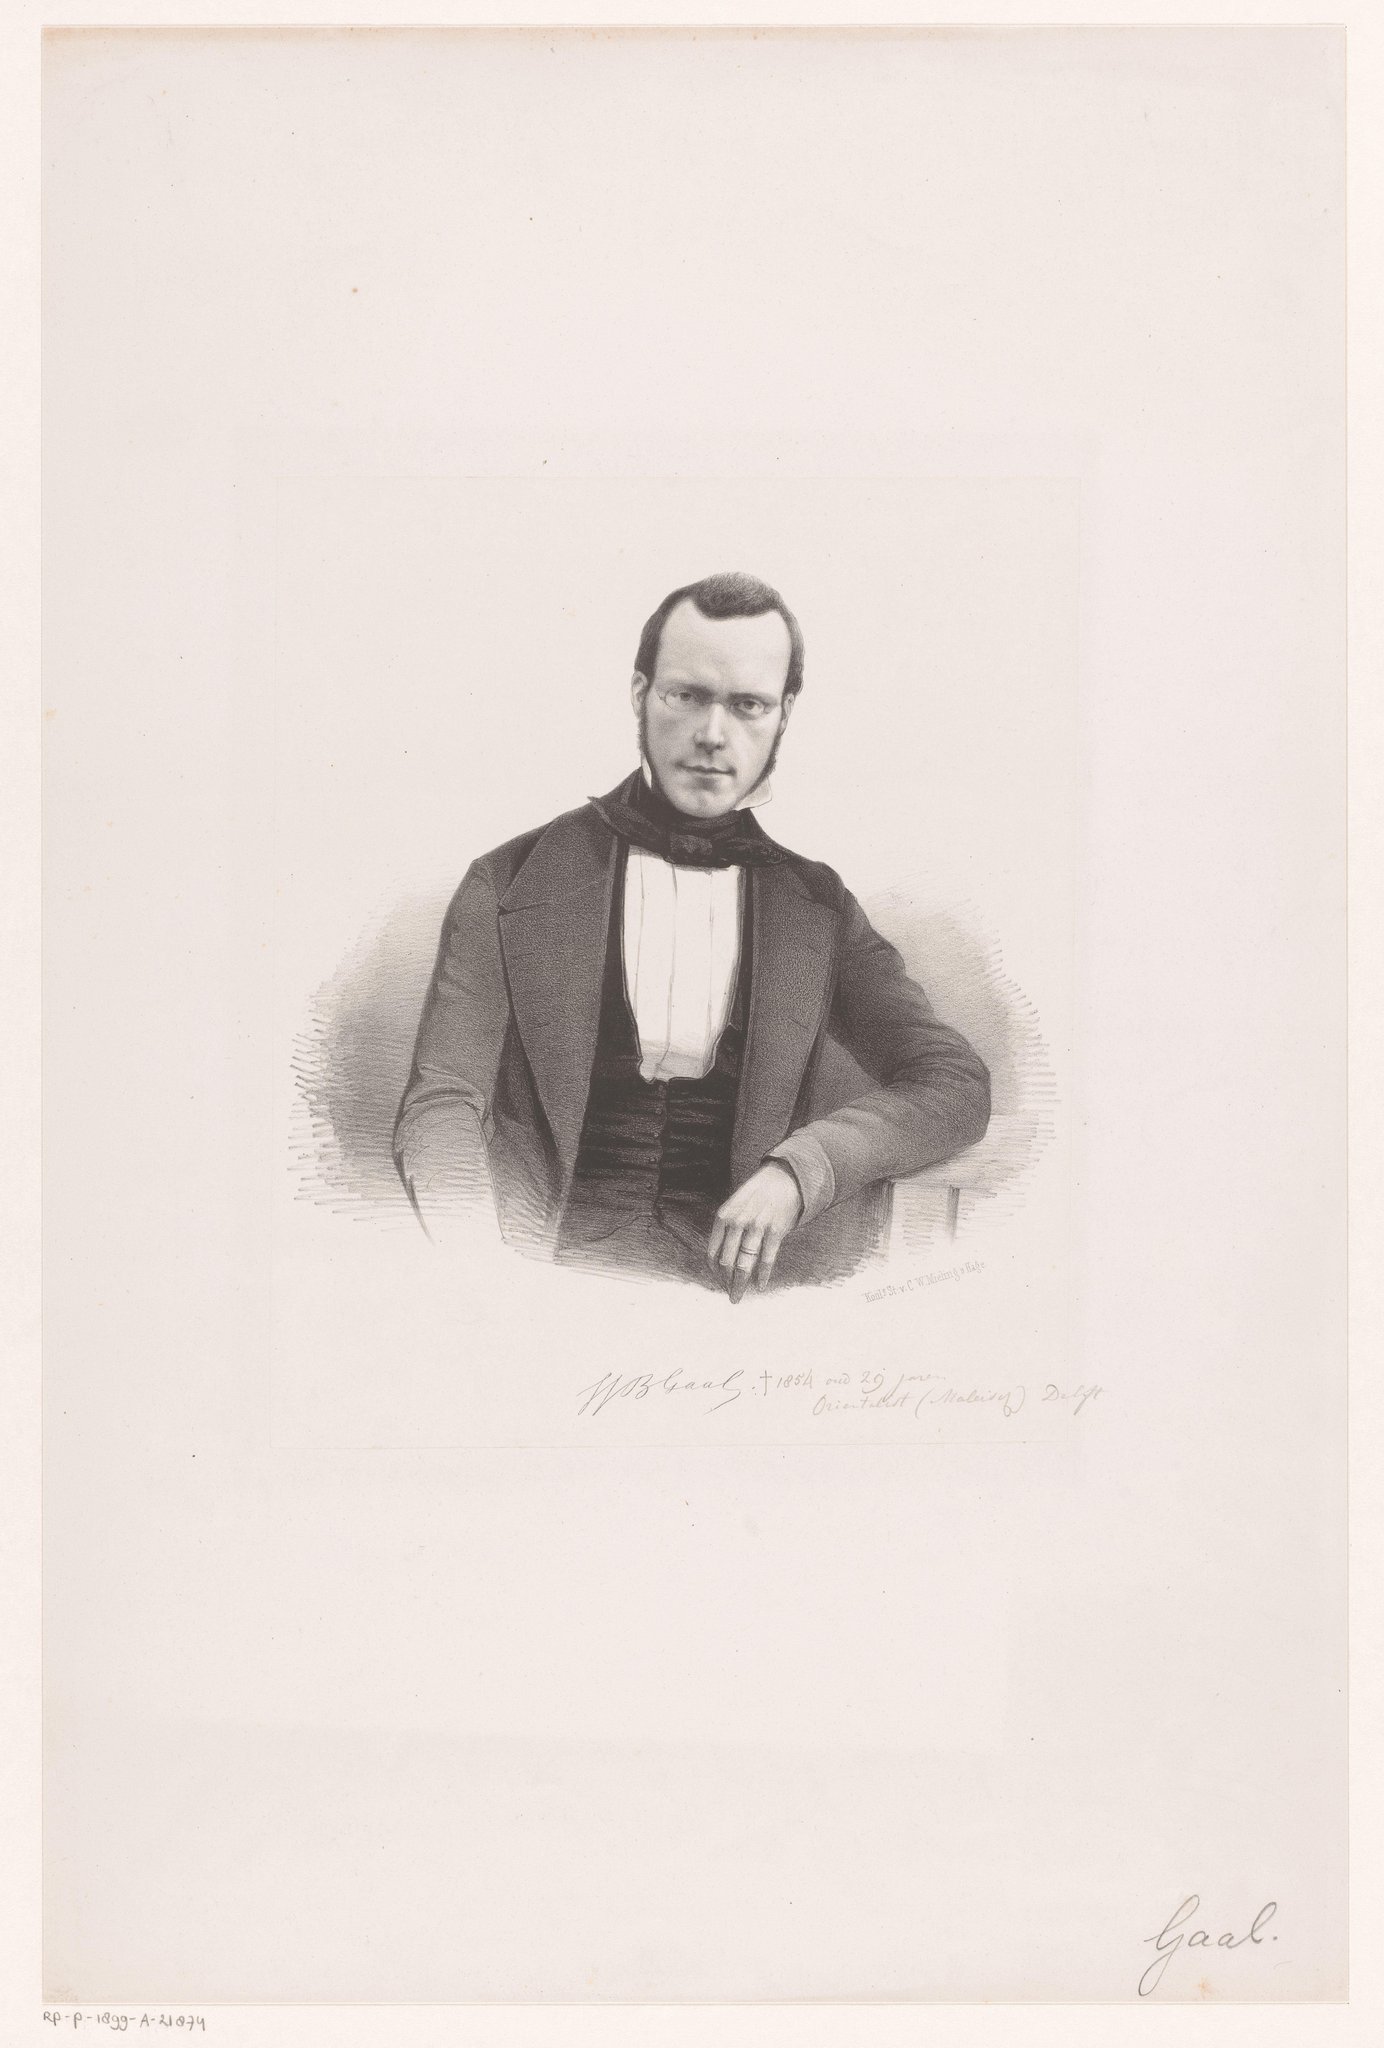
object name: print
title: Portret van Johannes Jacobus Beator Gaal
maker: Anonymous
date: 1847-1865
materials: paper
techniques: lithograph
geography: the hague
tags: delft, historical persons (+ half-length portrait)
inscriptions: collector's mark: Lugt 2228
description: Volgens Van Someren is deze prent gemaakt naar een schilderij van B. Gaal, de vader van de geportretteerde. Volgens het BP is de vader echter Jacobus Cornelis Gaal.